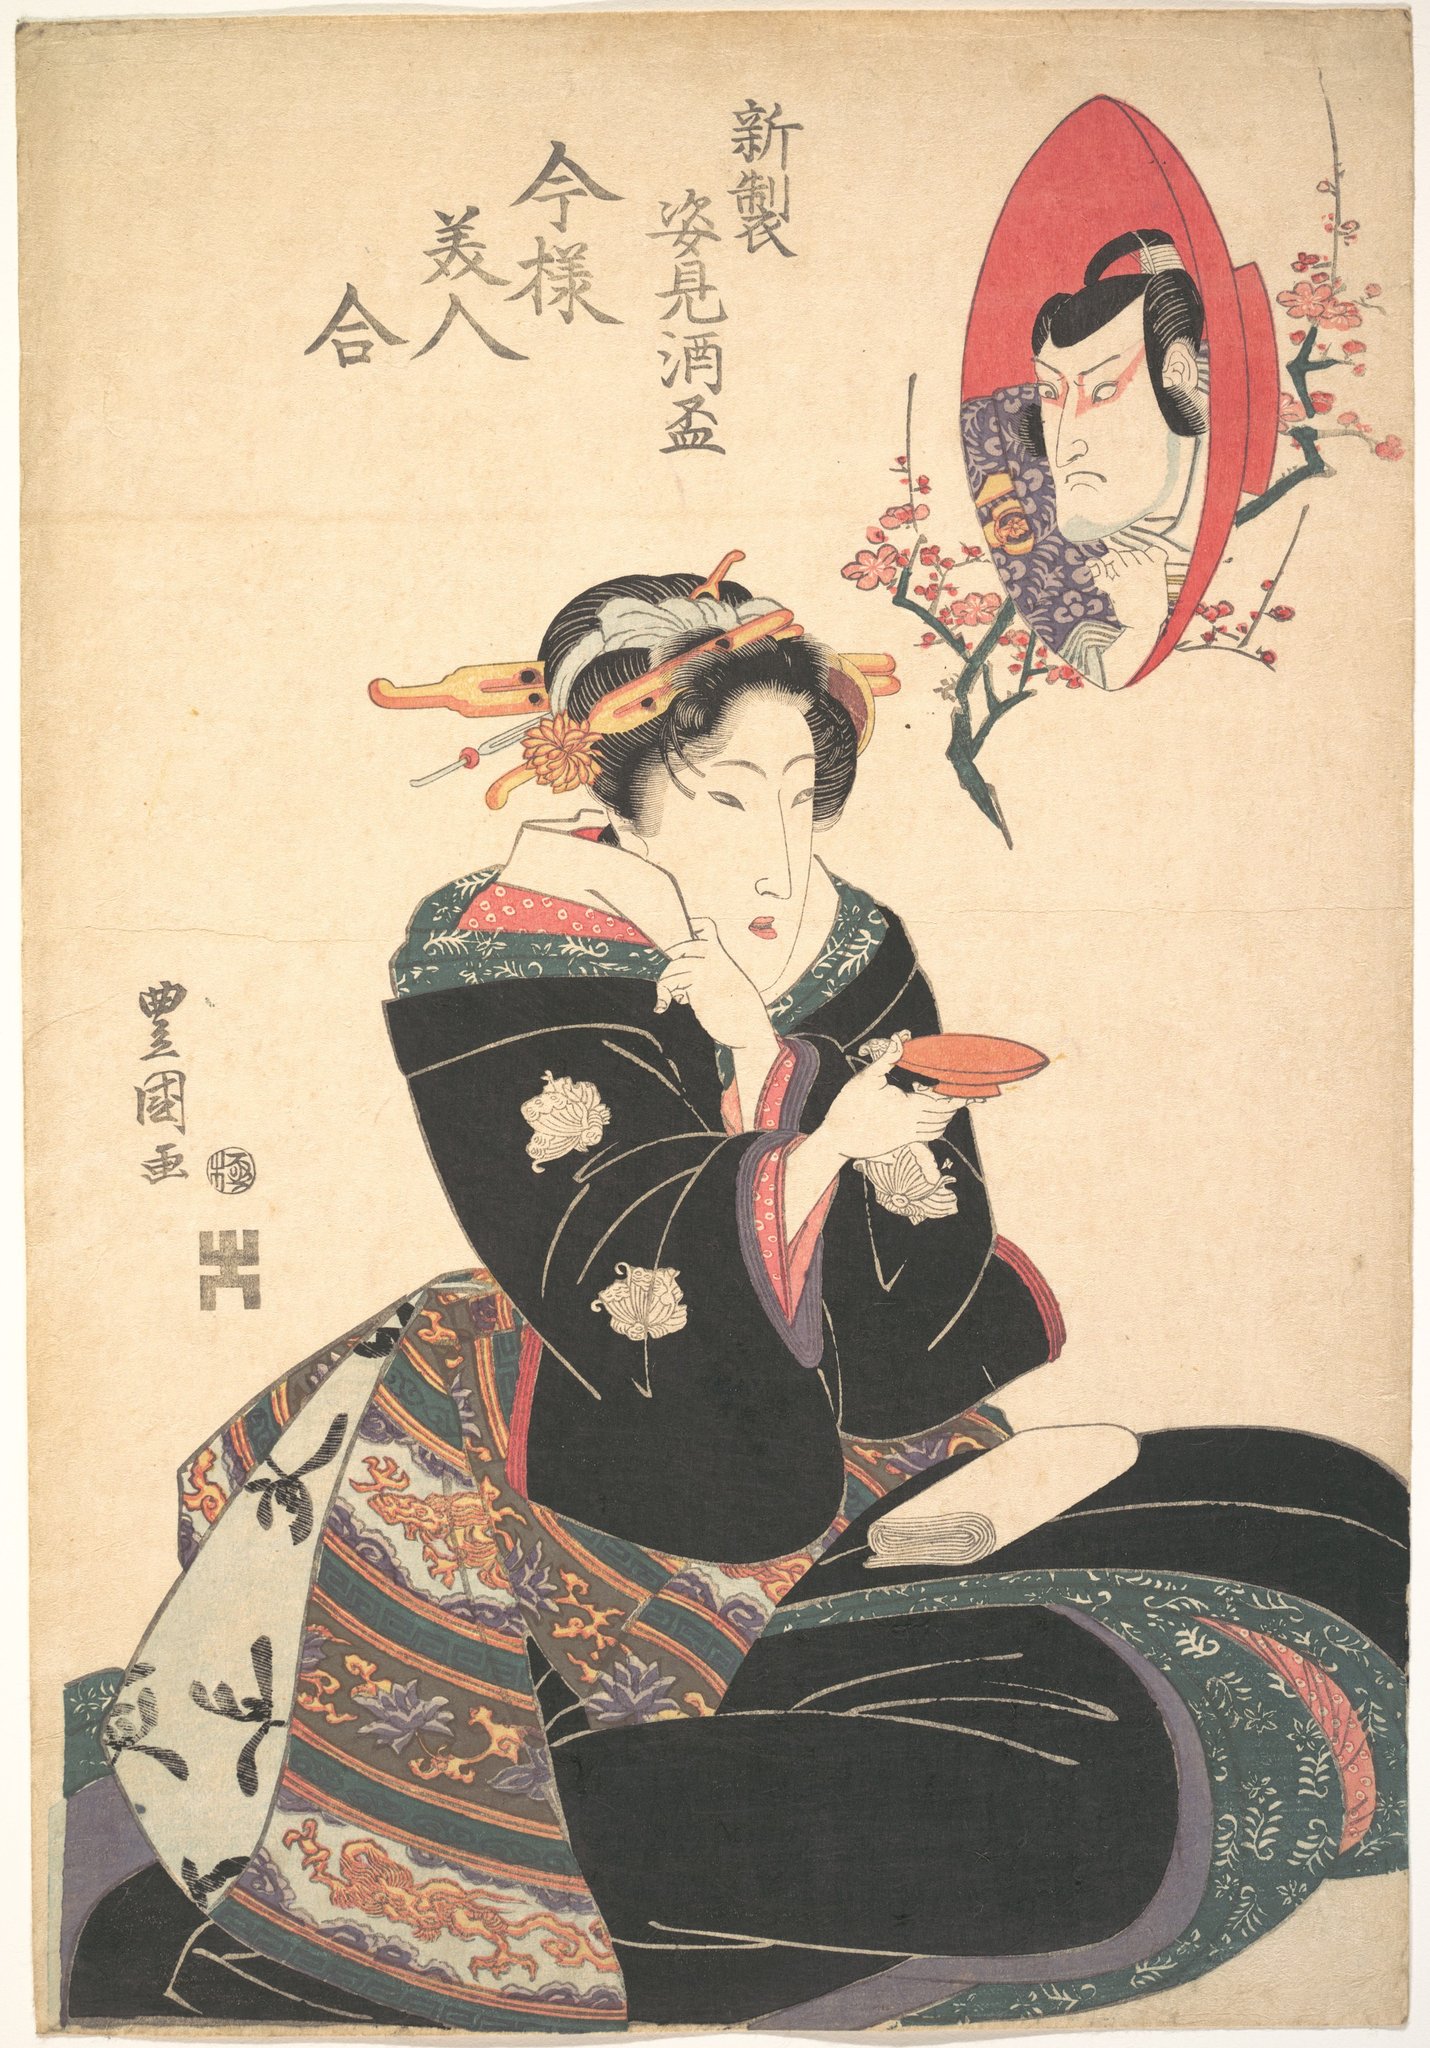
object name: print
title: An Actor's Image in a Sake Cup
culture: japanese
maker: utagawa toyoshige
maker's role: artist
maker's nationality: japanese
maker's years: 1802-1835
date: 1825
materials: ink, paper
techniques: woodblock print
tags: men,women,actors